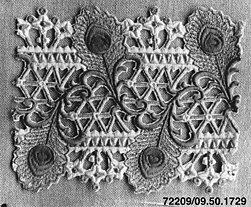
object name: passementerie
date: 1801-1900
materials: silk